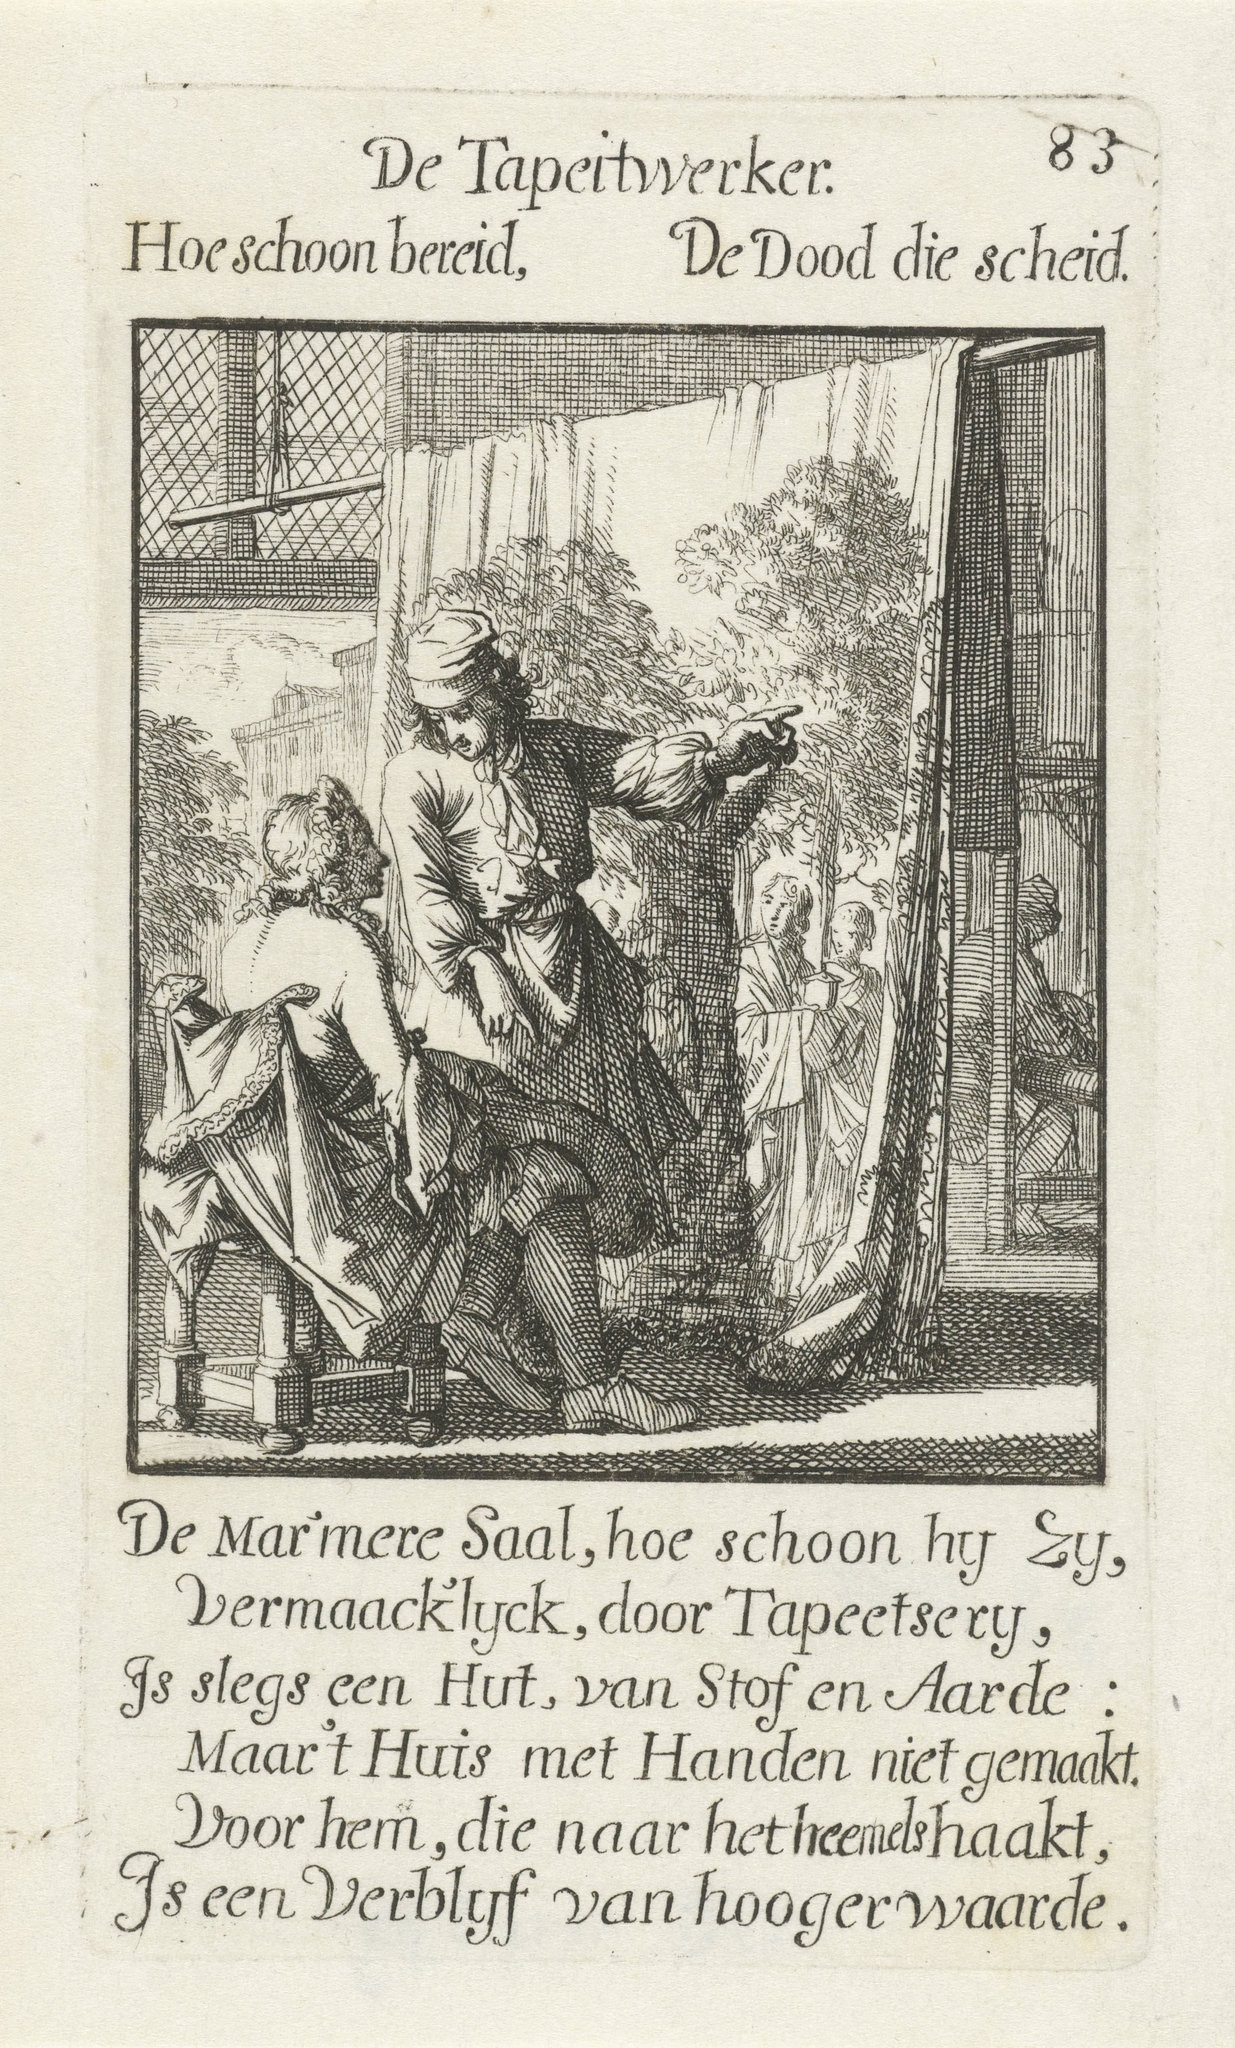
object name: print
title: Het Menselyk Bedryf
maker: jan luyken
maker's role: draughtsman, print maker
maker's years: 1649-1712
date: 1694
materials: paper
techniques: etching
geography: amsterdam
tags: handicrafts, craftsman at work, tapestry weaver, gobelin maker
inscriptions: collector's mark: Lugt 2228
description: Maakt deel uit van de 100-delige serie beroepsprenten van Jan en Caspar Luyken, getiteld: Het menselyk bedryf. S.l.s.n., 1694 (eerste druk).